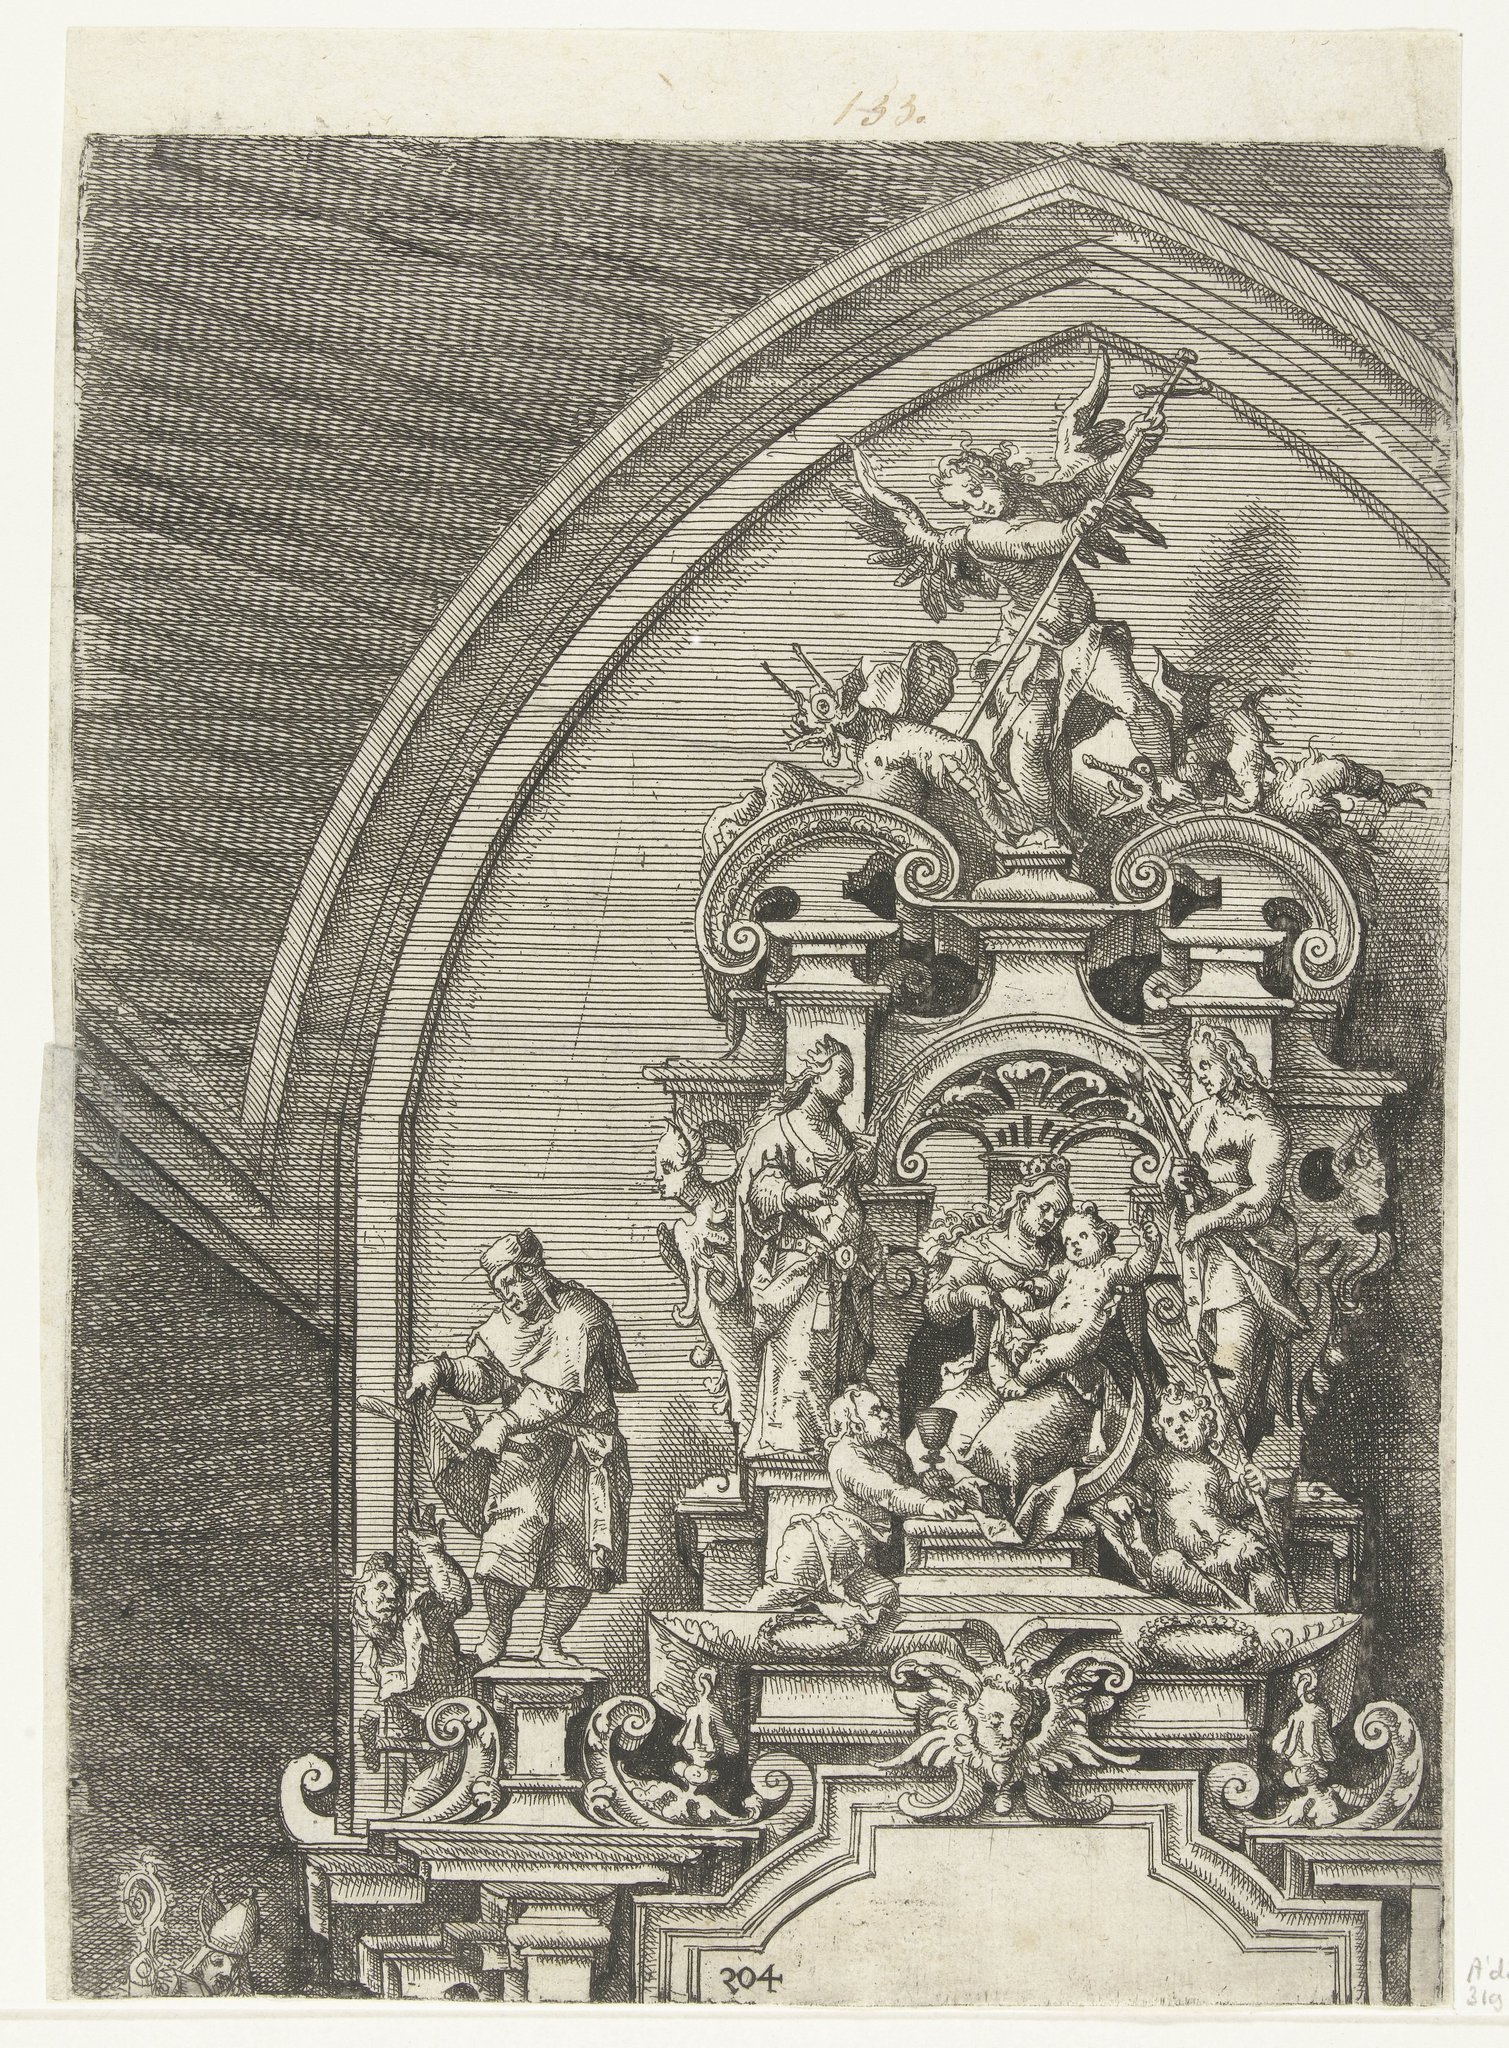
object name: ornament print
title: Bovenste gedeelte van een retabel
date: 1560-1598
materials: paper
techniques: etching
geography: germany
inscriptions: inscription: ‘133’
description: Bovenaan staat in een nis Maria met het kind op de maansikkel. Eén van 20 bladen uit een serie (Architectura. Von Ausztheilung, Symmetria und Proportion der fünff Seulen...) bestaande uit 193 bladen en 5 titelbladen, verdeeld over vijf boeken. Het gaat hier om een tweede, uitgebreide editie van de onder Orn Cat I-319 beschreven serie.